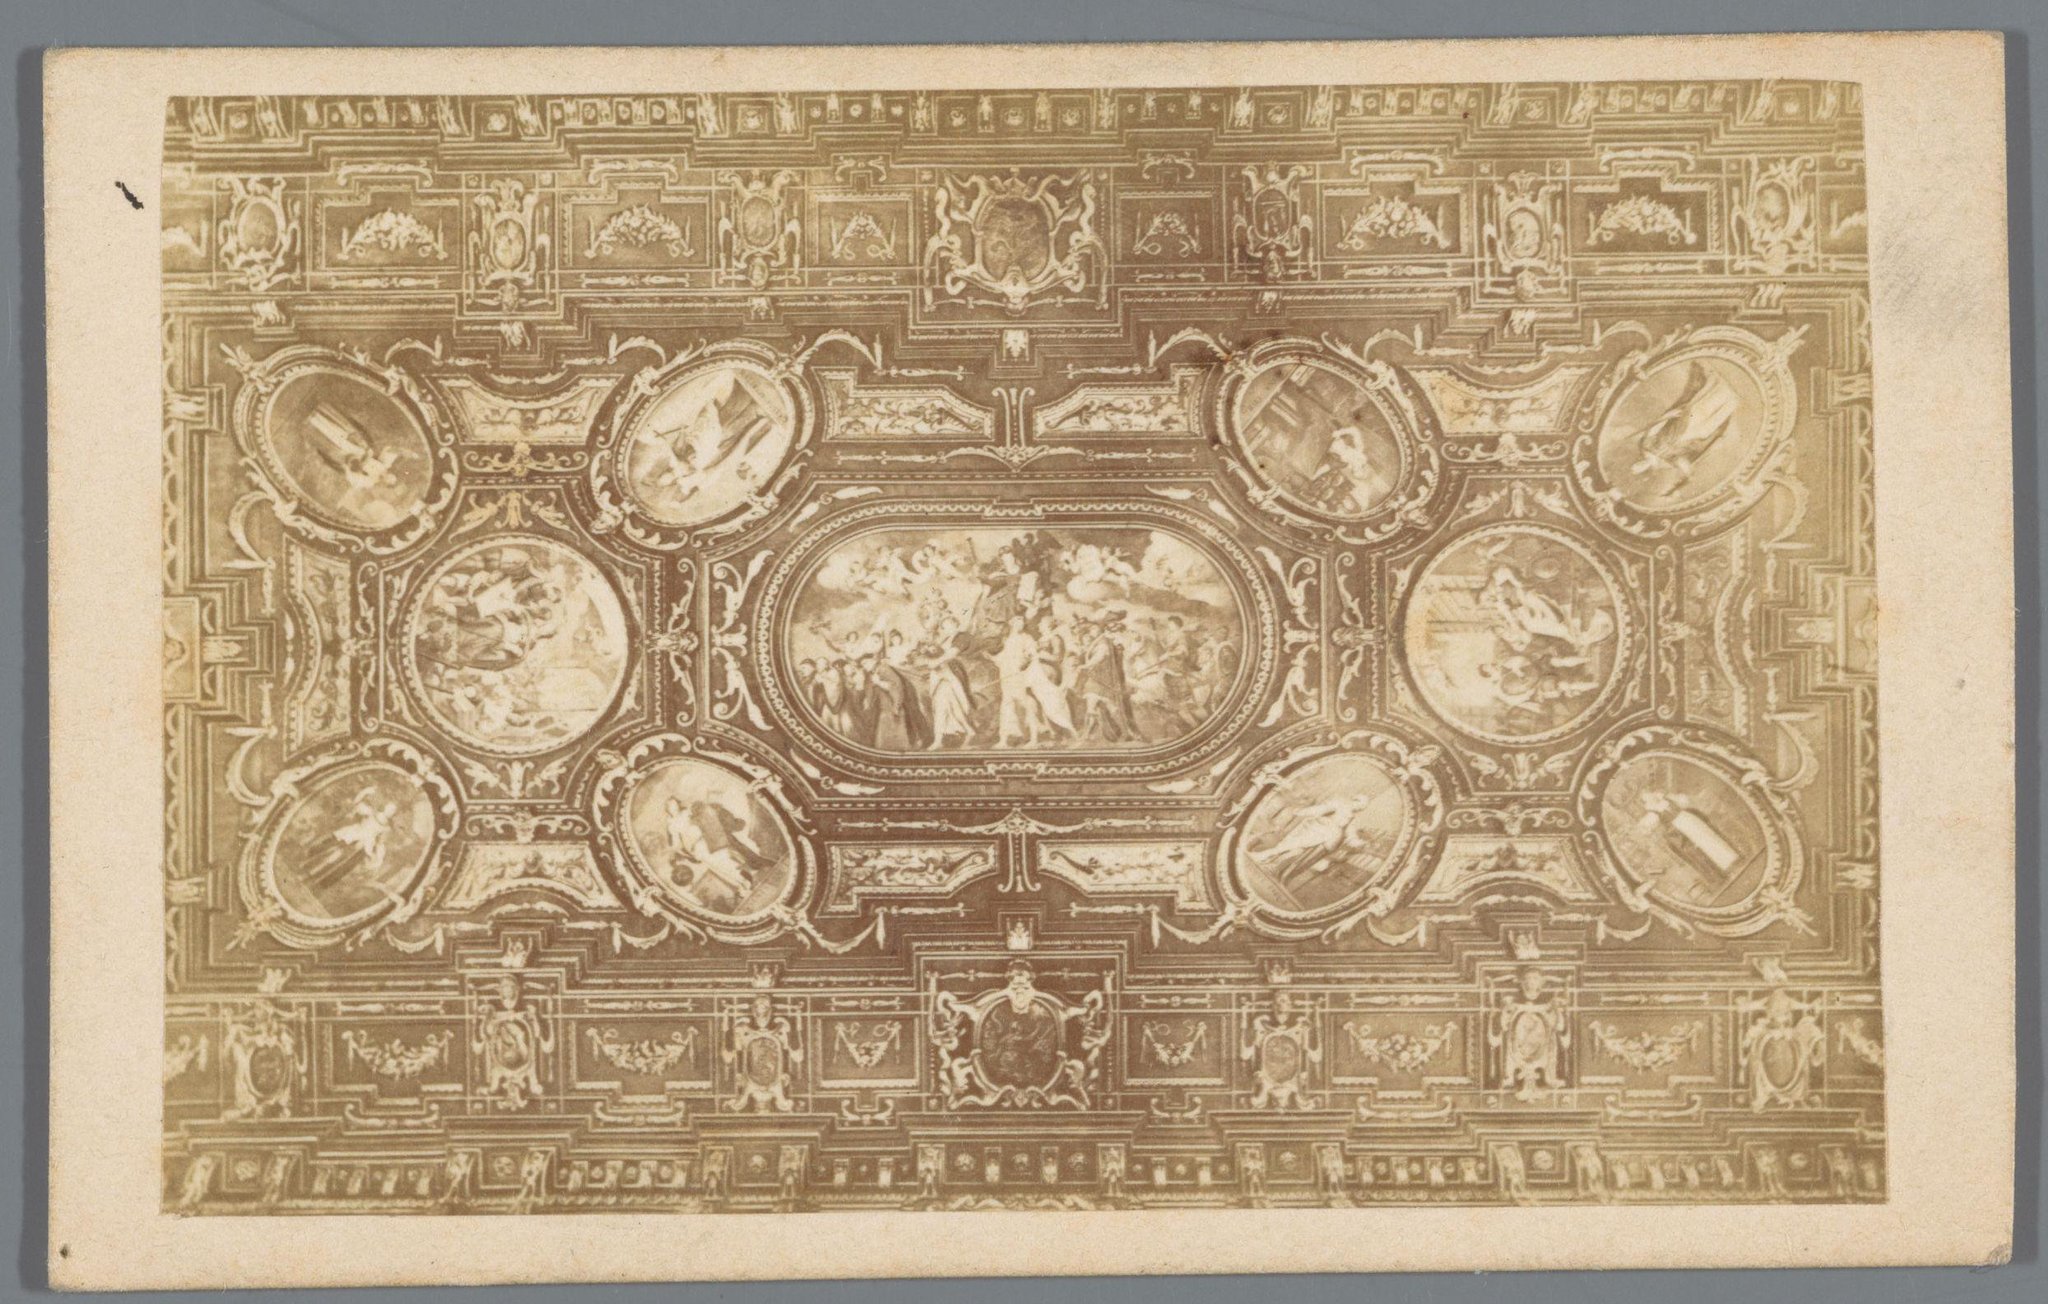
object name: carte de visite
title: Augsburg, Rathhaus, Plafond Saal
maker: carl jochaff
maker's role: fotograaf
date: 1855-1885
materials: cardboard, paper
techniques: albumen print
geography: augsburg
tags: (decorated) ceiling